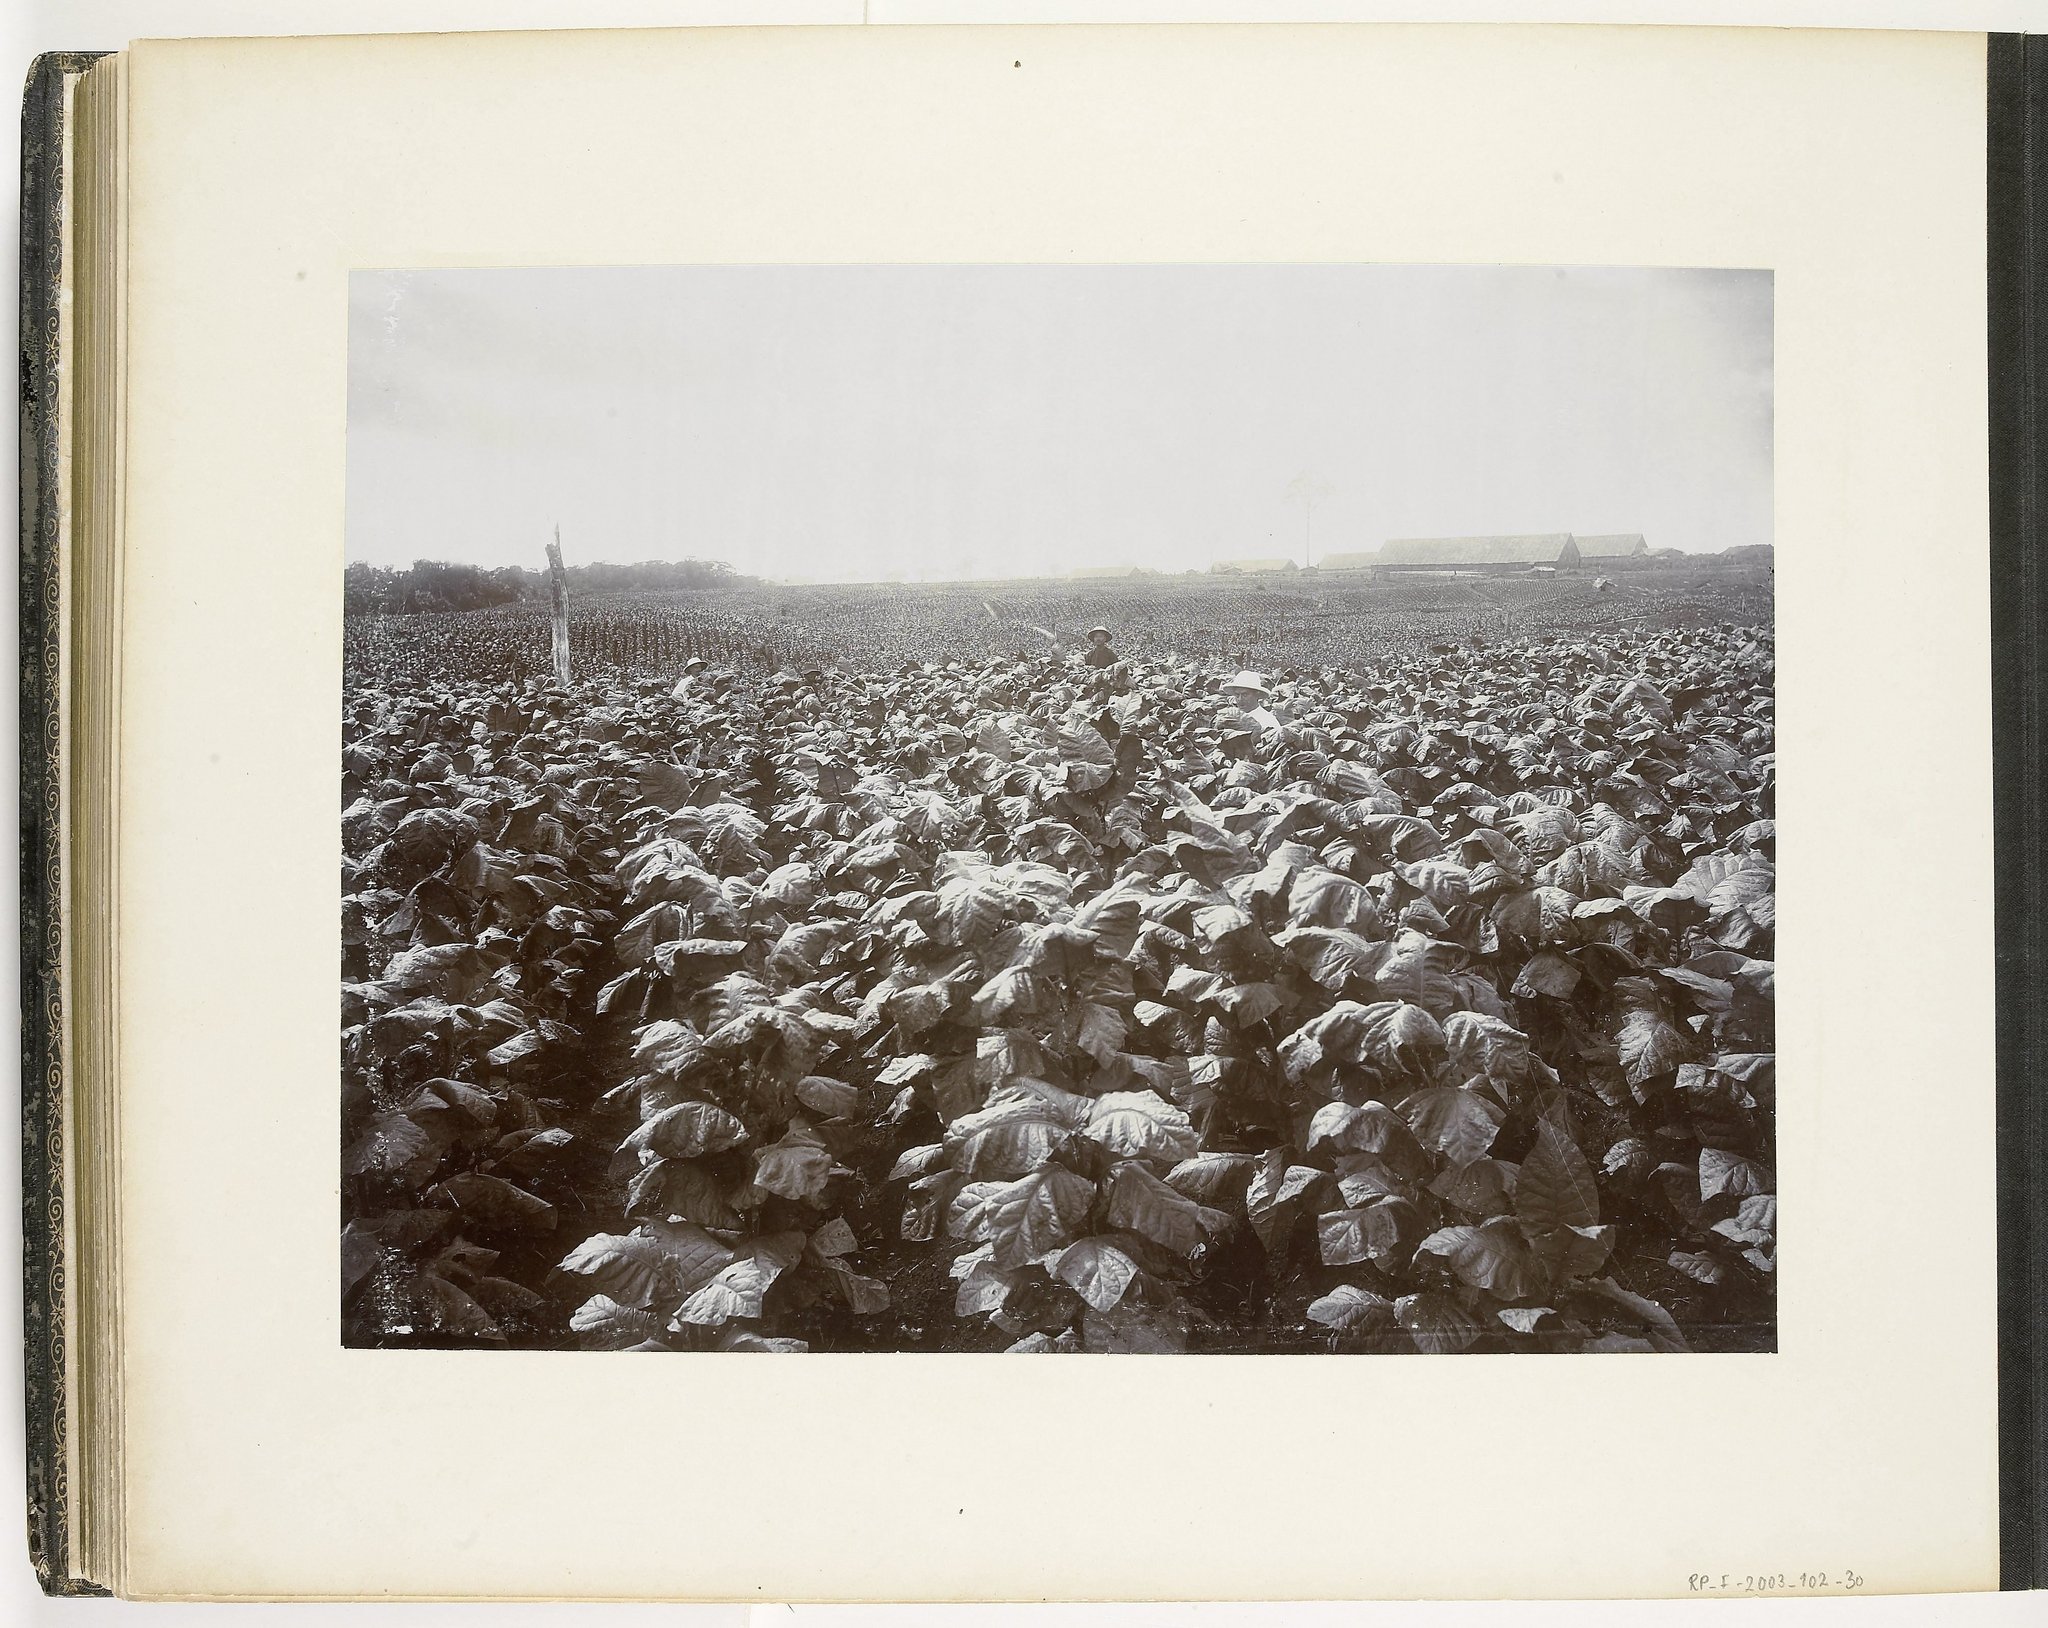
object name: photograph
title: Gezicht op de zaaivelden met rijpe tabaksplanten op de Rotterdam Estate, Sumatra (Reifer Taback Rotterdam Estate)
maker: carl j. kleingrothe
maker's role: fotograaf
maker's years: 1864-1925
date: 1890-1900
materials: photographic support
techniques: collodion silver print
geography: sumatra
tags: sumatra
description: Gezicht op de velden met rijpe tabaksplanten op de plantage Rotterdam Estate op Sumatra. Tussen de planten enkele personeelsleden. Onderdeel van het Sumatra fotoalbum van Paul en Lucie Sandel uit 1900.